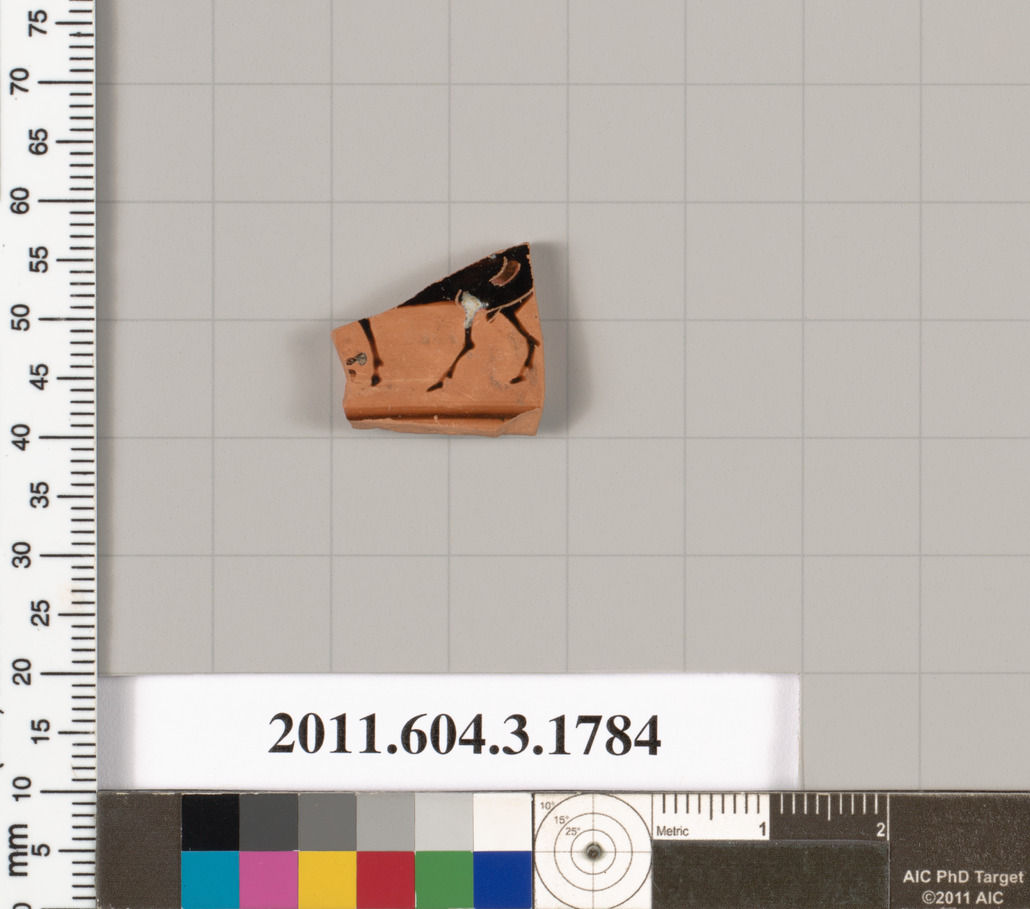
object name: kylix fragment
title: Terracotta fragment of a kylix: Lip cup (drinking cup)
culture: greek, attic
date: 560-550 BCE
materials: terracotta